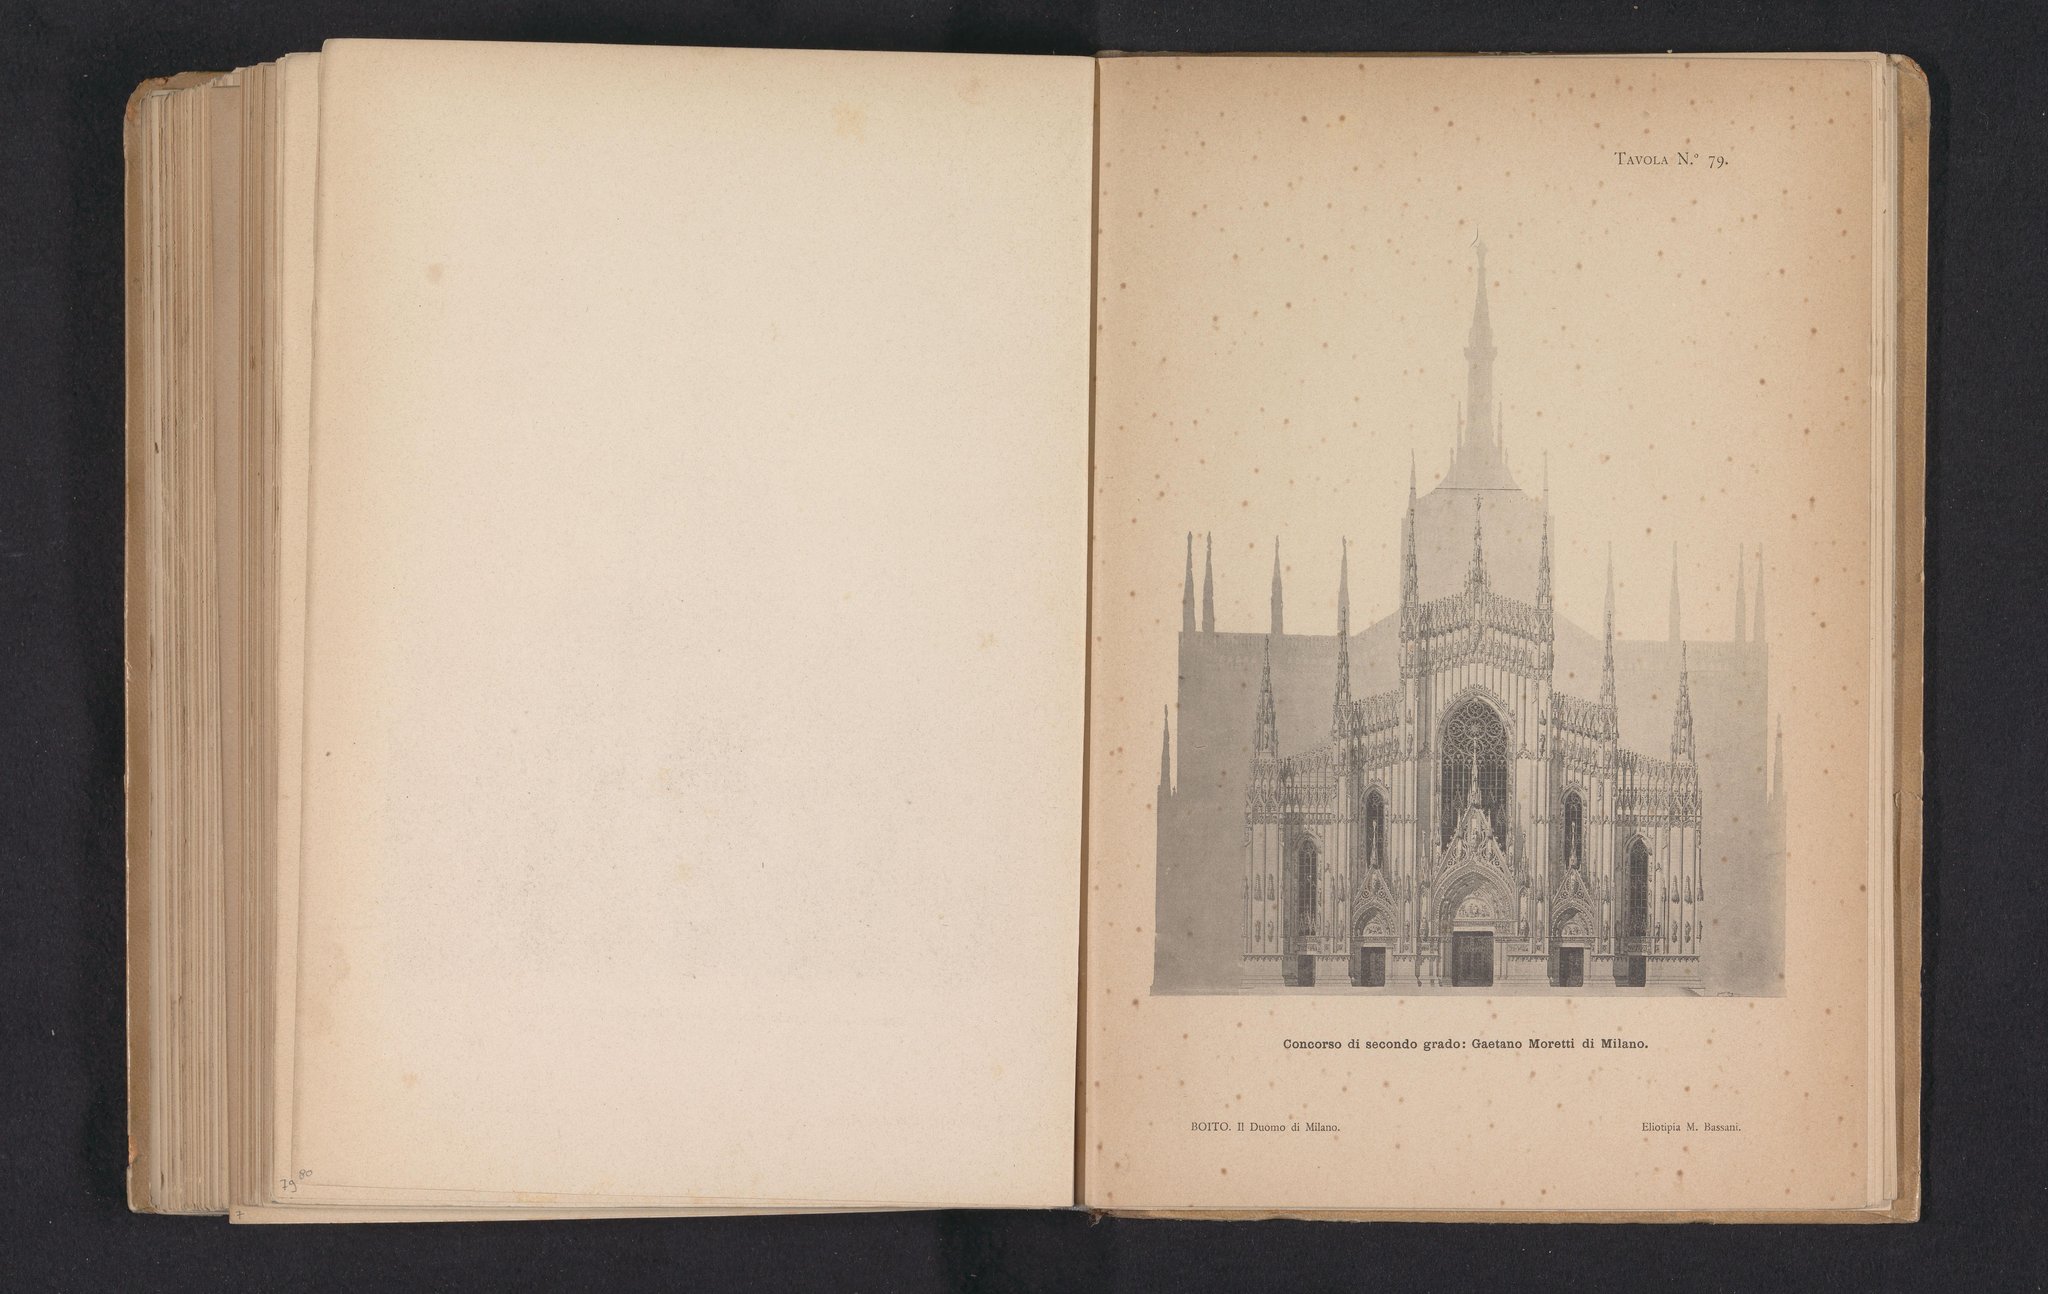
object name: page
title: Fotoreproductie van een ontwerptekening voor de façade van de Dom van Milaan door Gaetano Moretti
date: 1886-1889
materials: paper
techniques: photograph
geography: milan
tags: drawing, sketch, parts of church exterior and annexes: façade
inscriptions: number: ‘Tavola No. 79.’